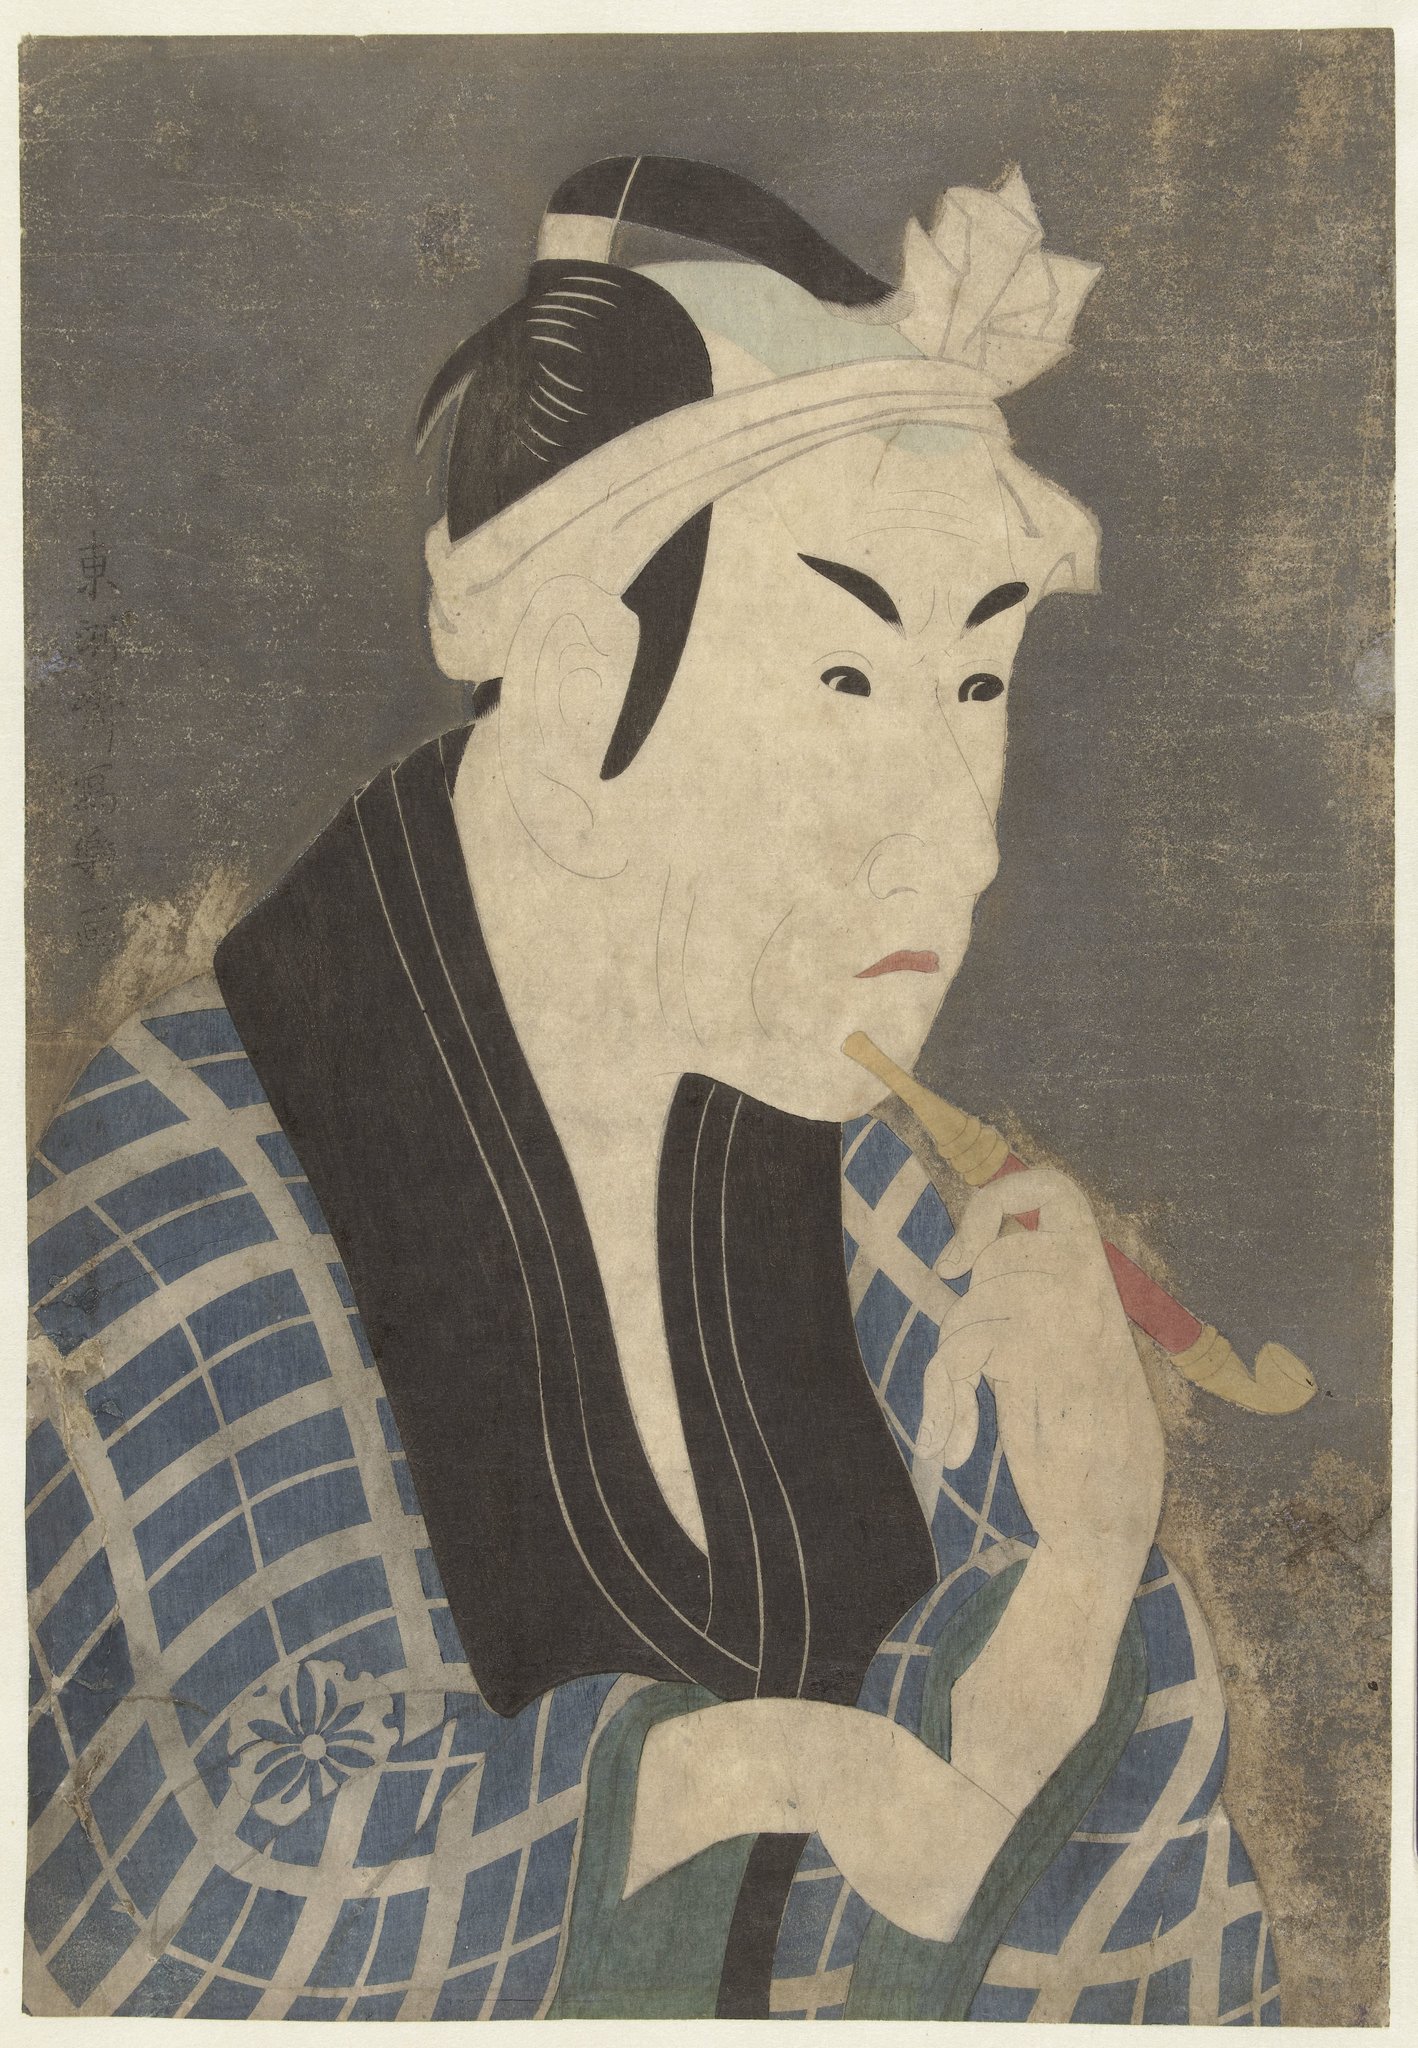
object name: print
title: Busteportret van Matsumoto Koshiro IV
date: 1900-1925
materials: paper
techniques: woodcut, nishiki e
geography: tokyo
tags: kyoto, pipe ~ tobacco, portrait of actor, actress, fisherman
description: De acteur Matsumoto Koshiro IV in de rol van de vishandelaar Sakanaya Gorobei, met pijp in linker hand; tegen donkergrijze mica achtergrond. Scene uit het toneelstuk Katakiuchi noriaibanashi, opgevoerd in het Kiri-za in 1794.